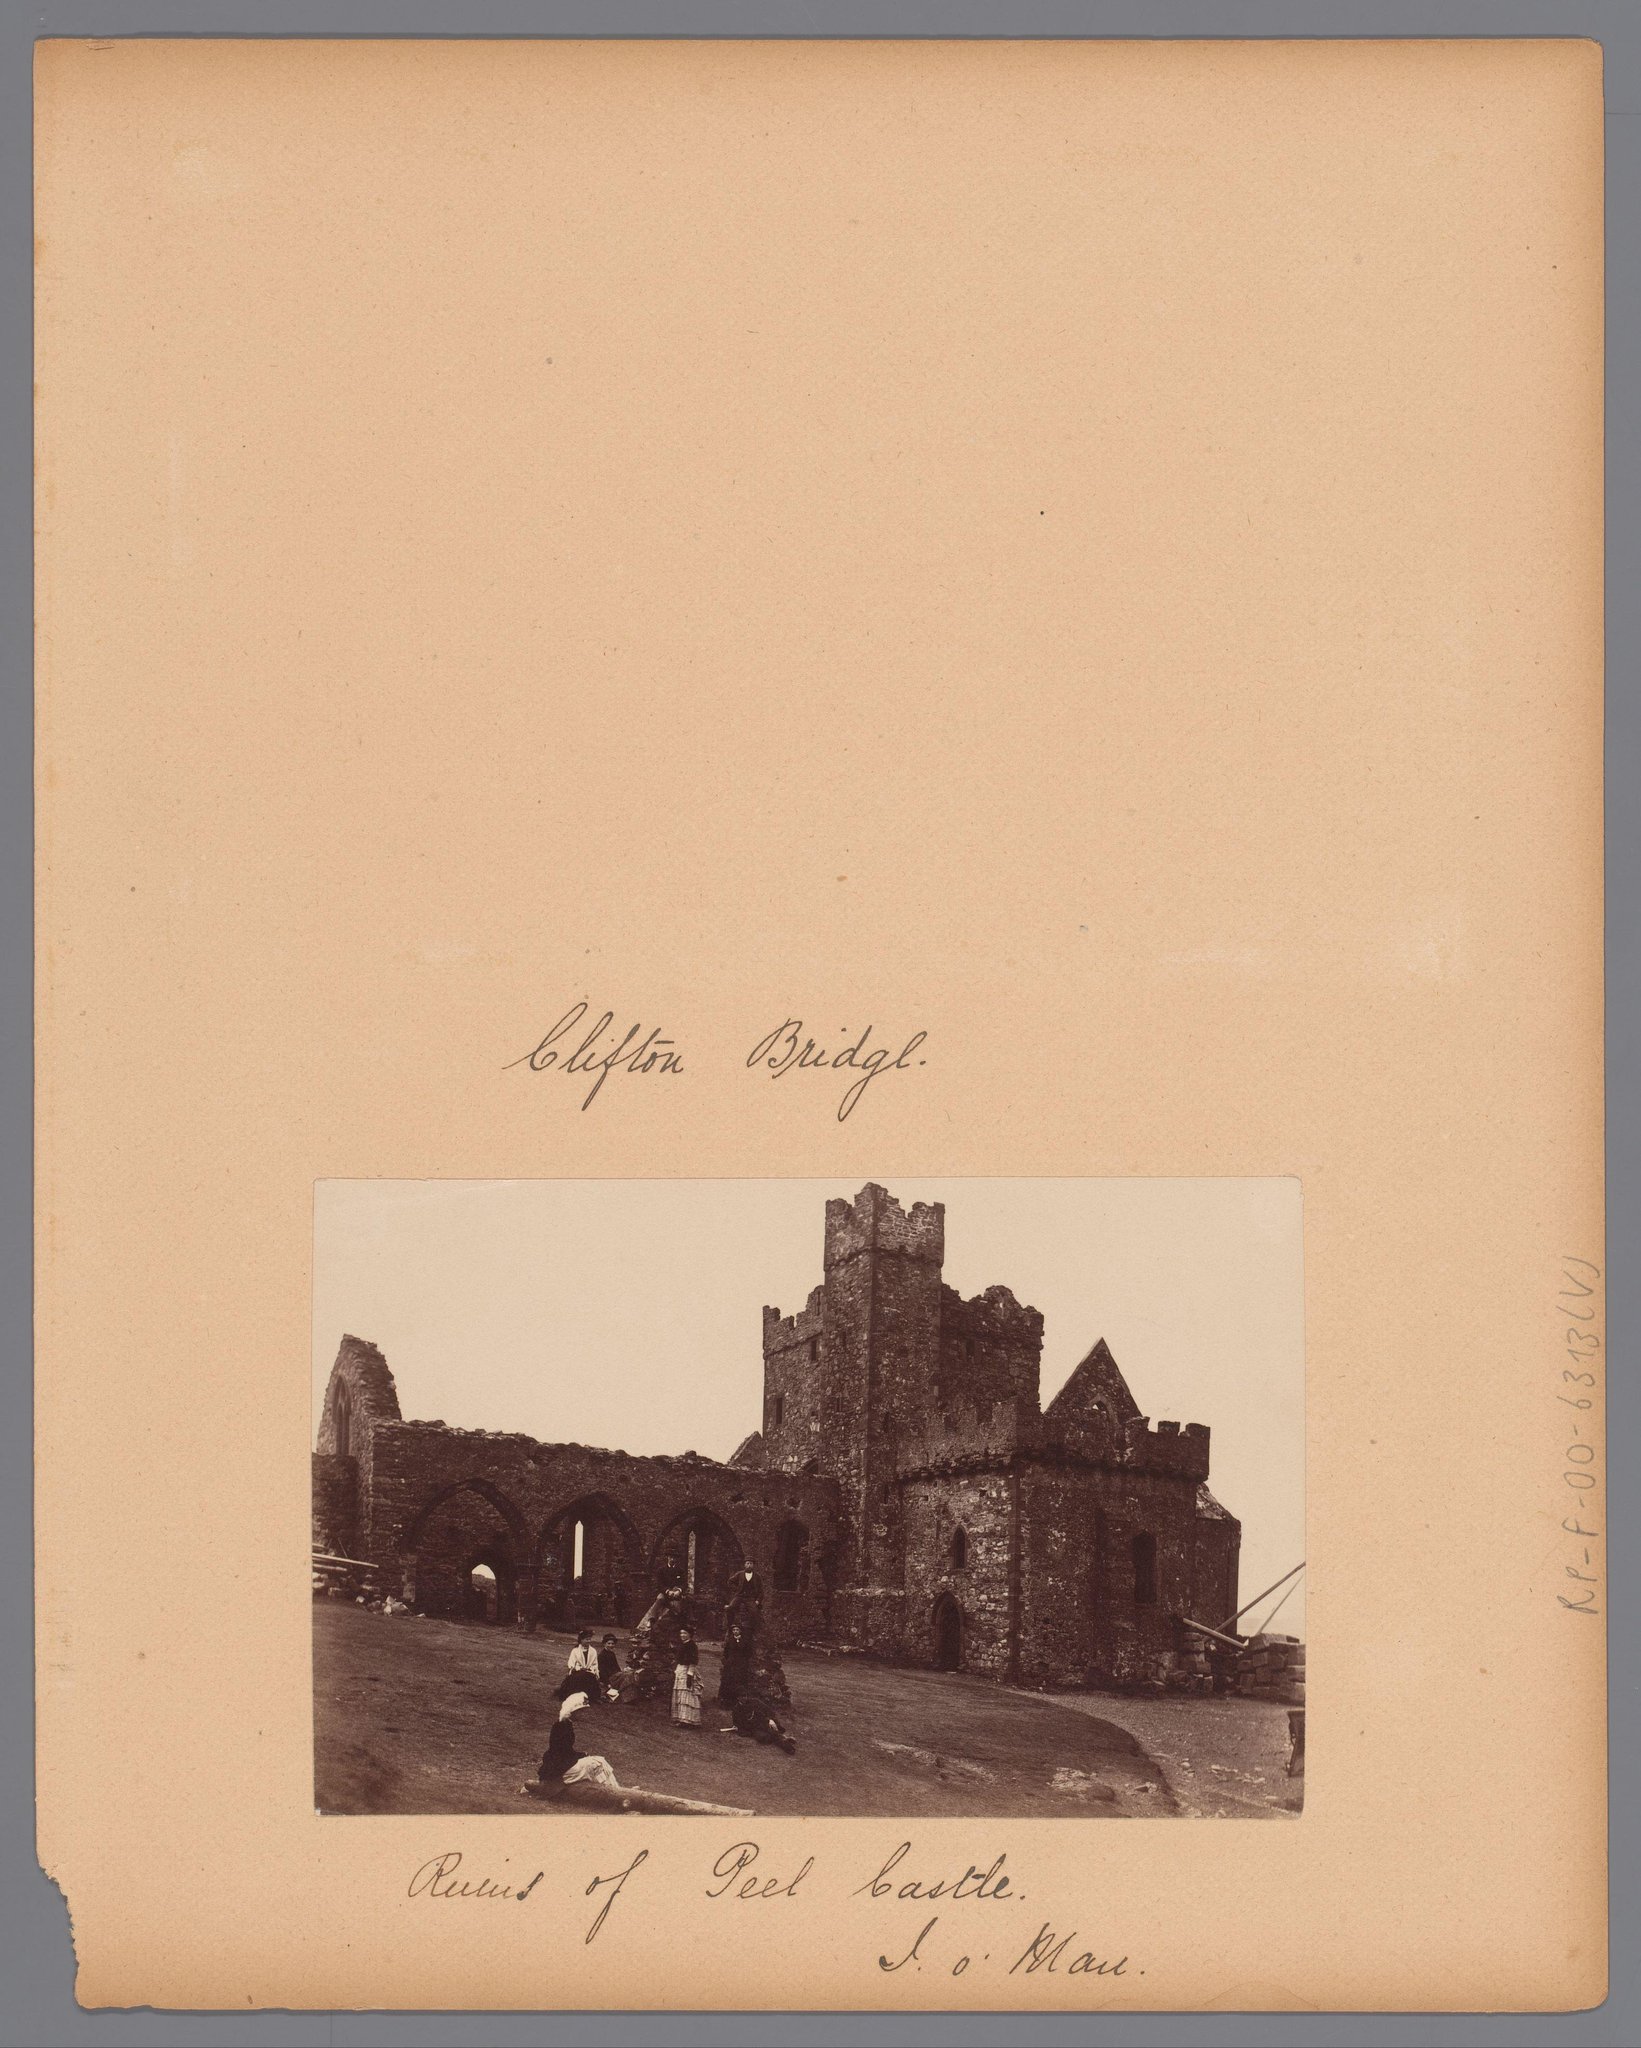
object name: photograph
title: Ruins of Peel Castle, Isle of Man, Verenigd Koninkrijk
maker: Anonymous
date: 1875-1890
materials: cardboard, paper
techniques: albumen print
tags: great britain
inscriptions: caption: ‘Clifton Bridge’, caption: ‘Ruins of Peel Castle.//I. o. Man.’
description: Ruines, met daarvoor een gezelschap mannen en vrouwen staand en zittend in het gras. Vergelijk RP-F-00-6312.